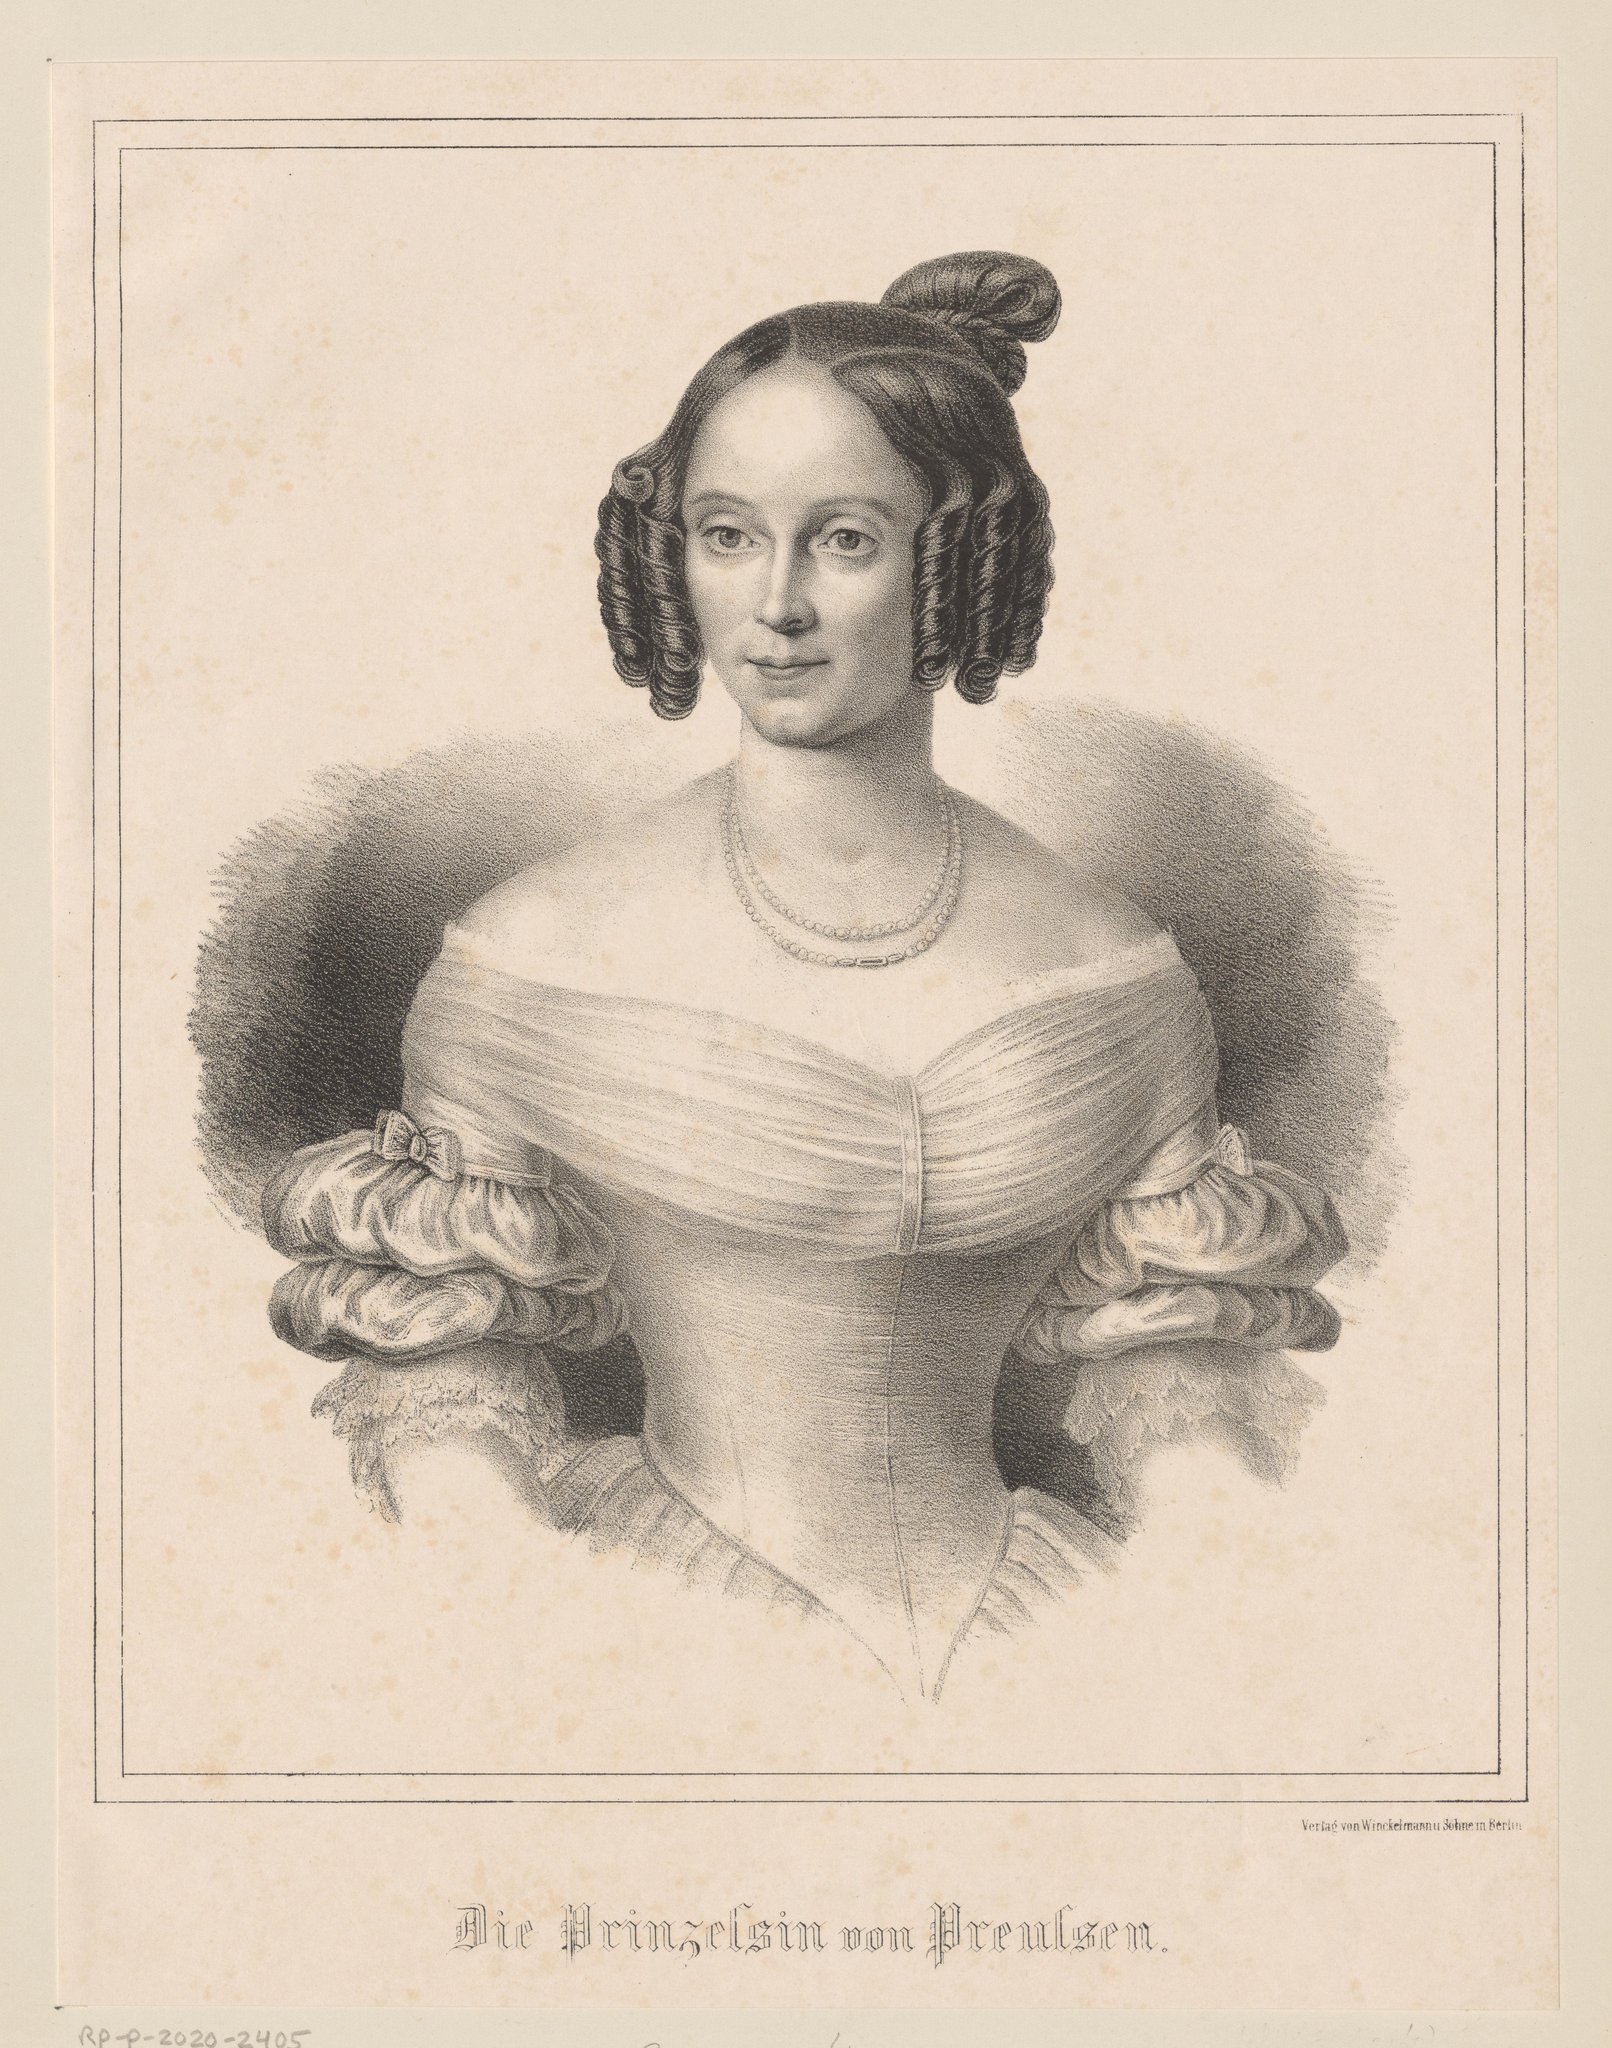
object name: print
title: Portret van Elisabeth Ludovika van Beieren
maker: Anonymous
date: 1830-1840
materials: paper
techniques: lithograph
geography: berlin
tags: historical persons - bb - woman